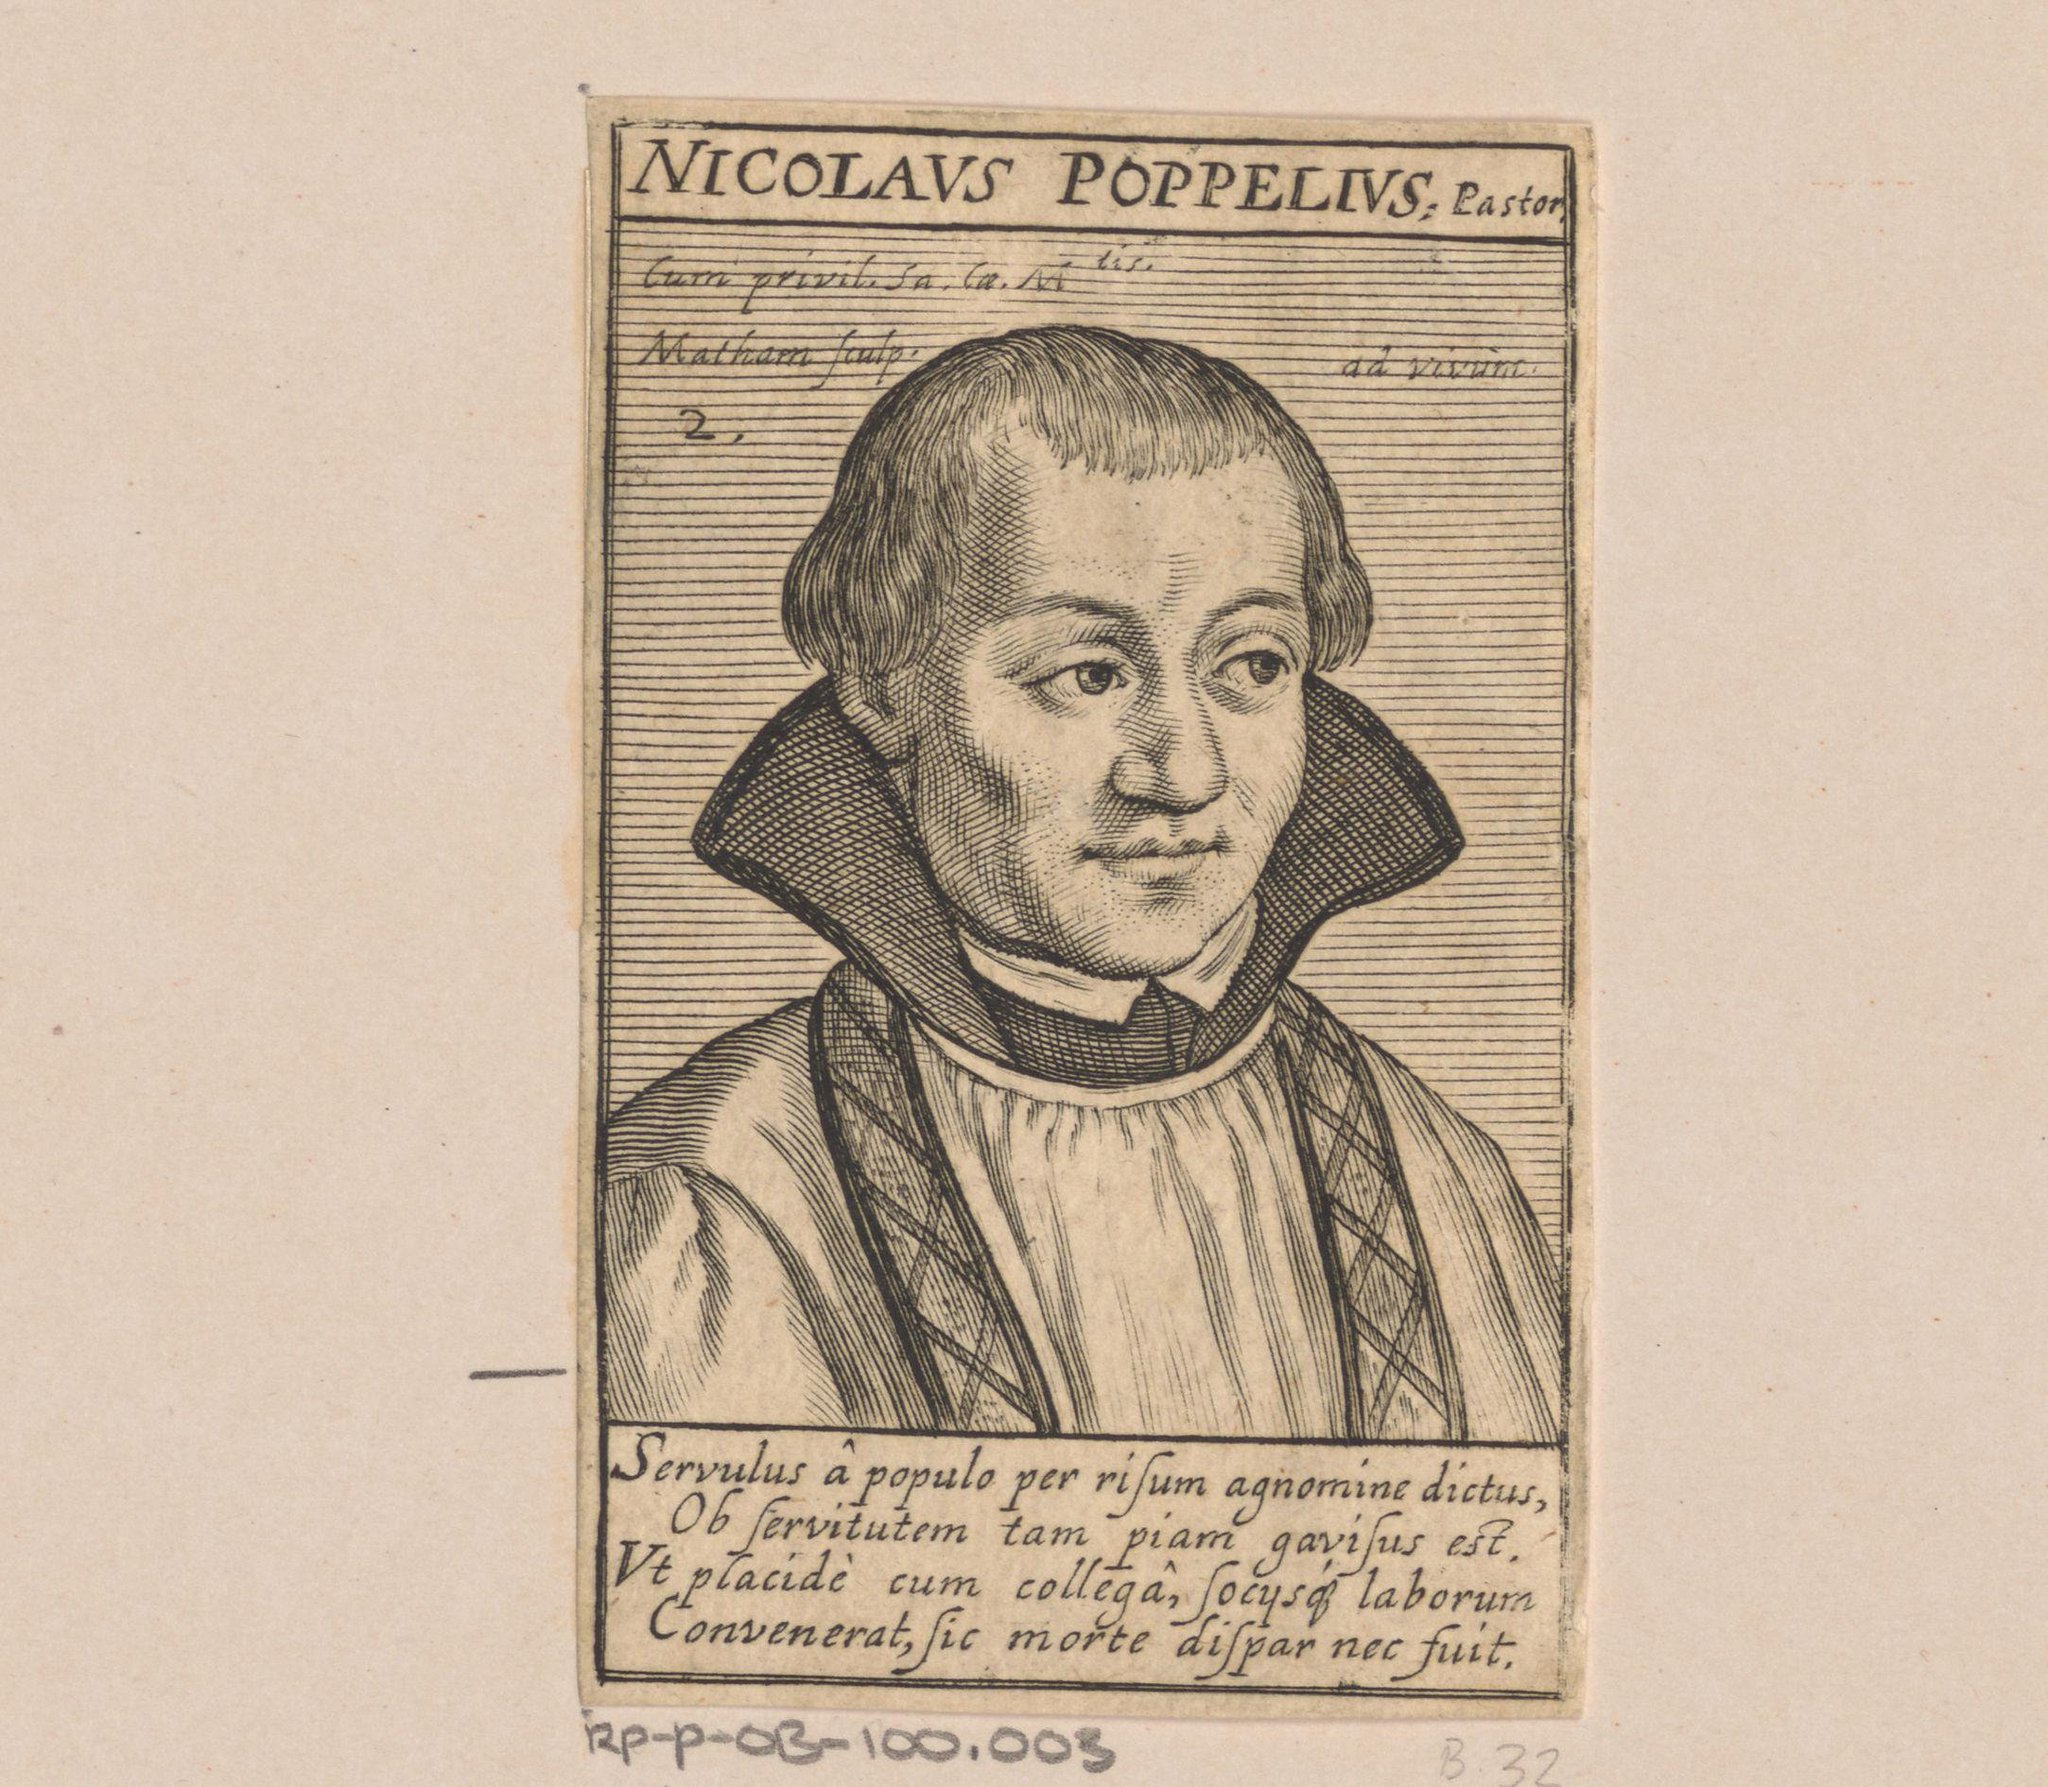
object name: print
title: Portret van H. Nicolaas Poppel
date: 1617-1618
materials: paper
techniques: engraving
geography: haarlem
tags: martyrs of gorkum, historical persons, brielle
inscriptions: collector's mark: Lugt 964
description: Met vierregelig onderschrift in het Latijn. Genummerd: 2.